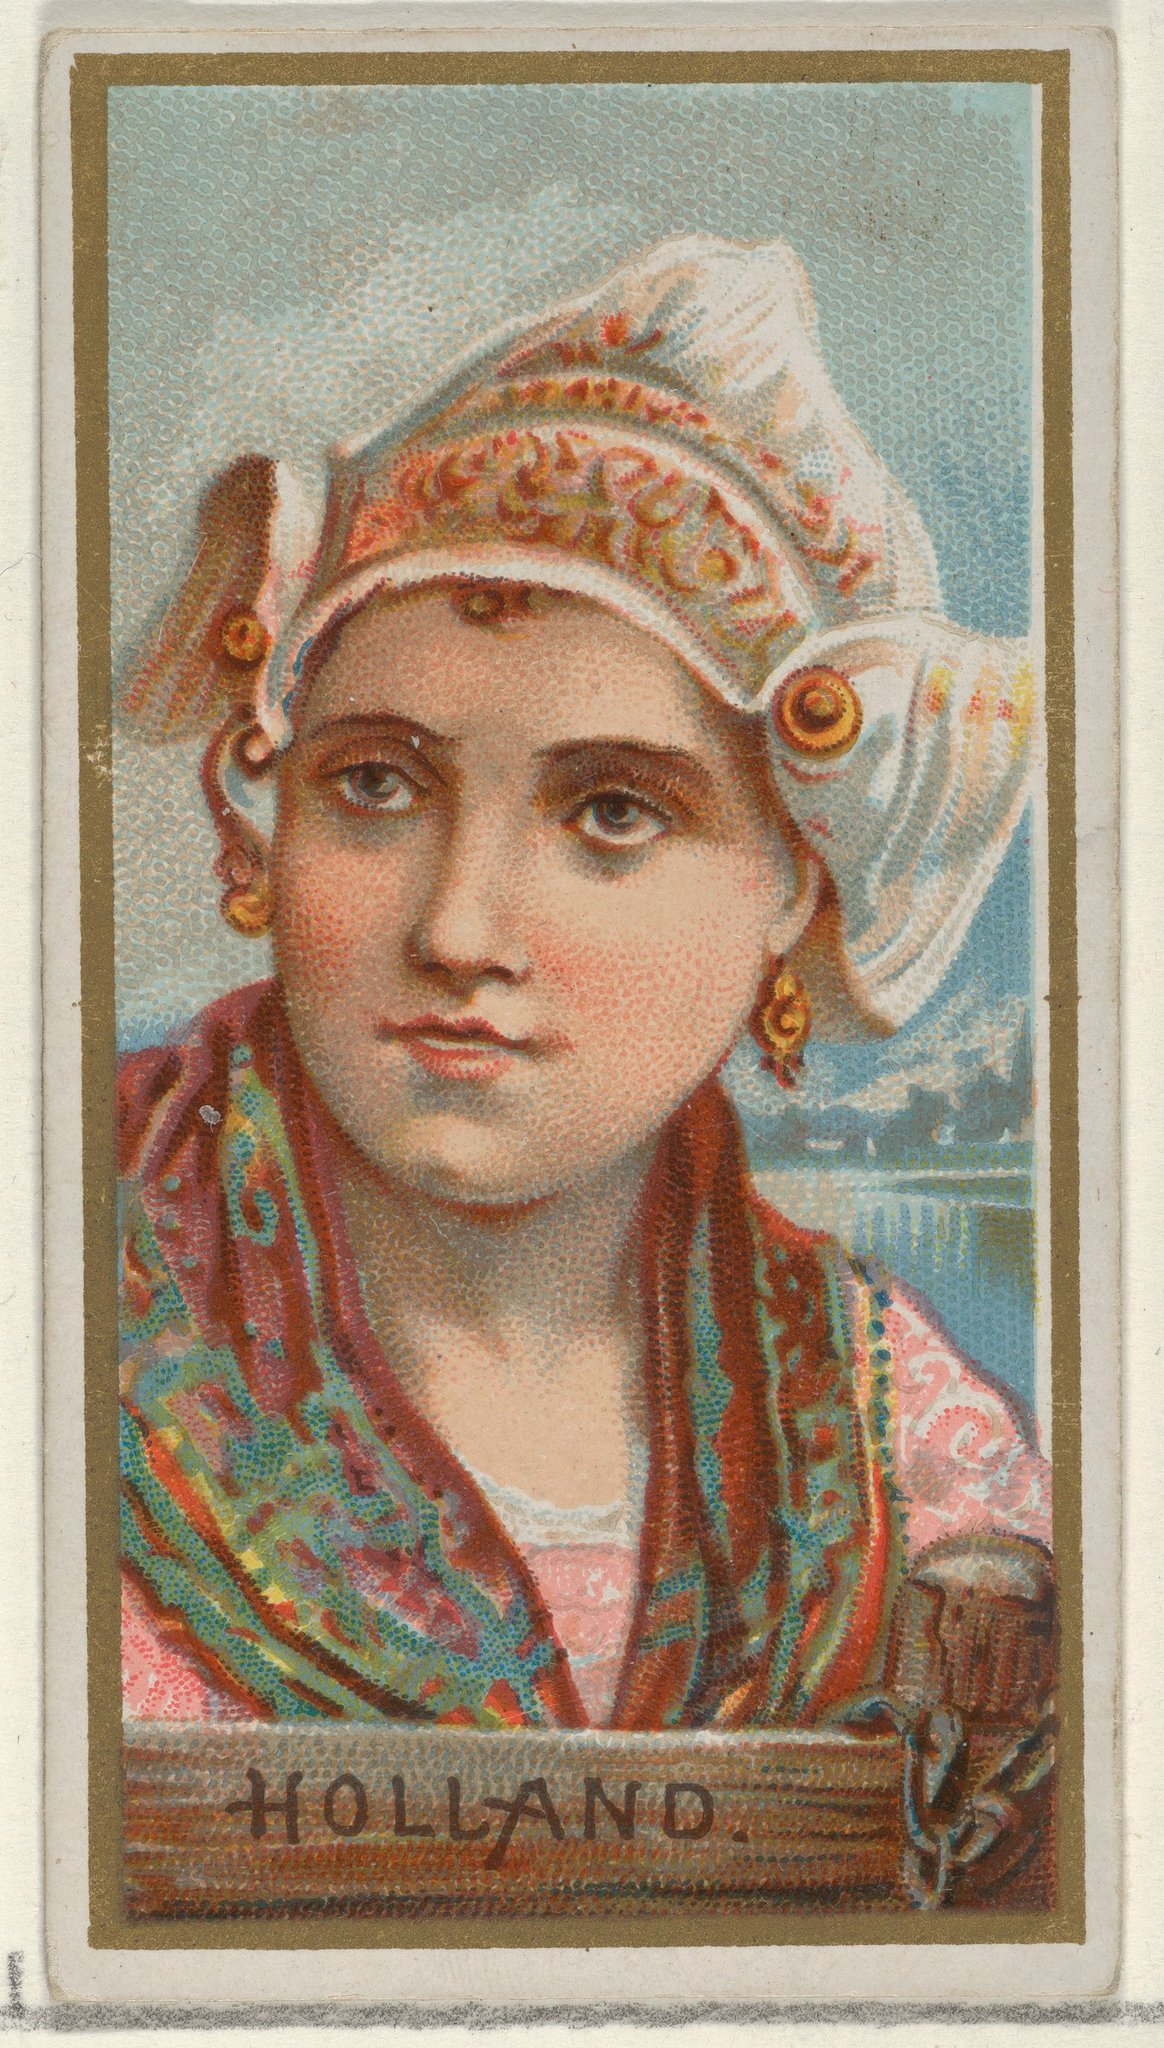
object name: print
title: Holland, from the Types of All Nations series (N24) for Allen & Ginter Cigarettes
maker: allen & ginter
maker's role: publisher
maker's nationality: american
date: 1889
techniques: color lithograph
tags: women